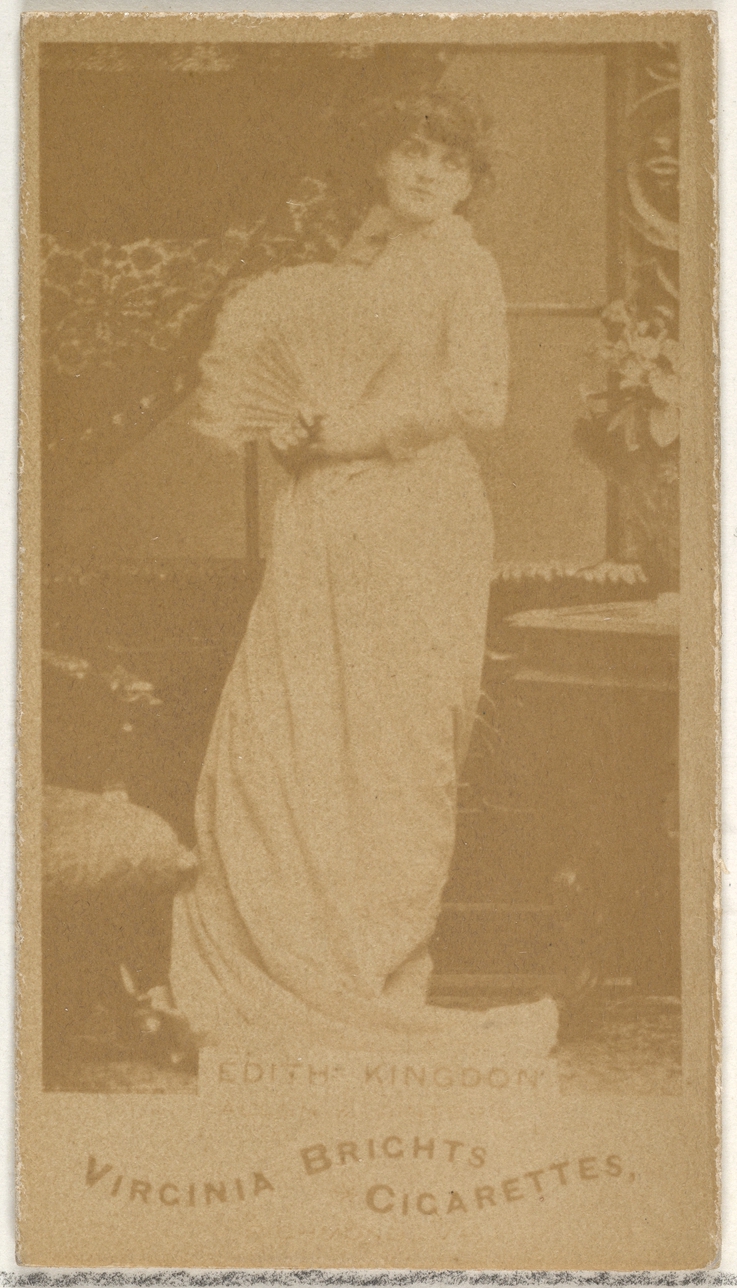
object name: photograph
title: Edith Kingdon, from the Actors and Actresses series (N45, Type 1) for Virginia Brights Cigarettes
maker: allen & ginter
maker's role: publisher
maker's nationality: american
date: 1888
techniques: albumen silver print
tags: portraits,women,actresses